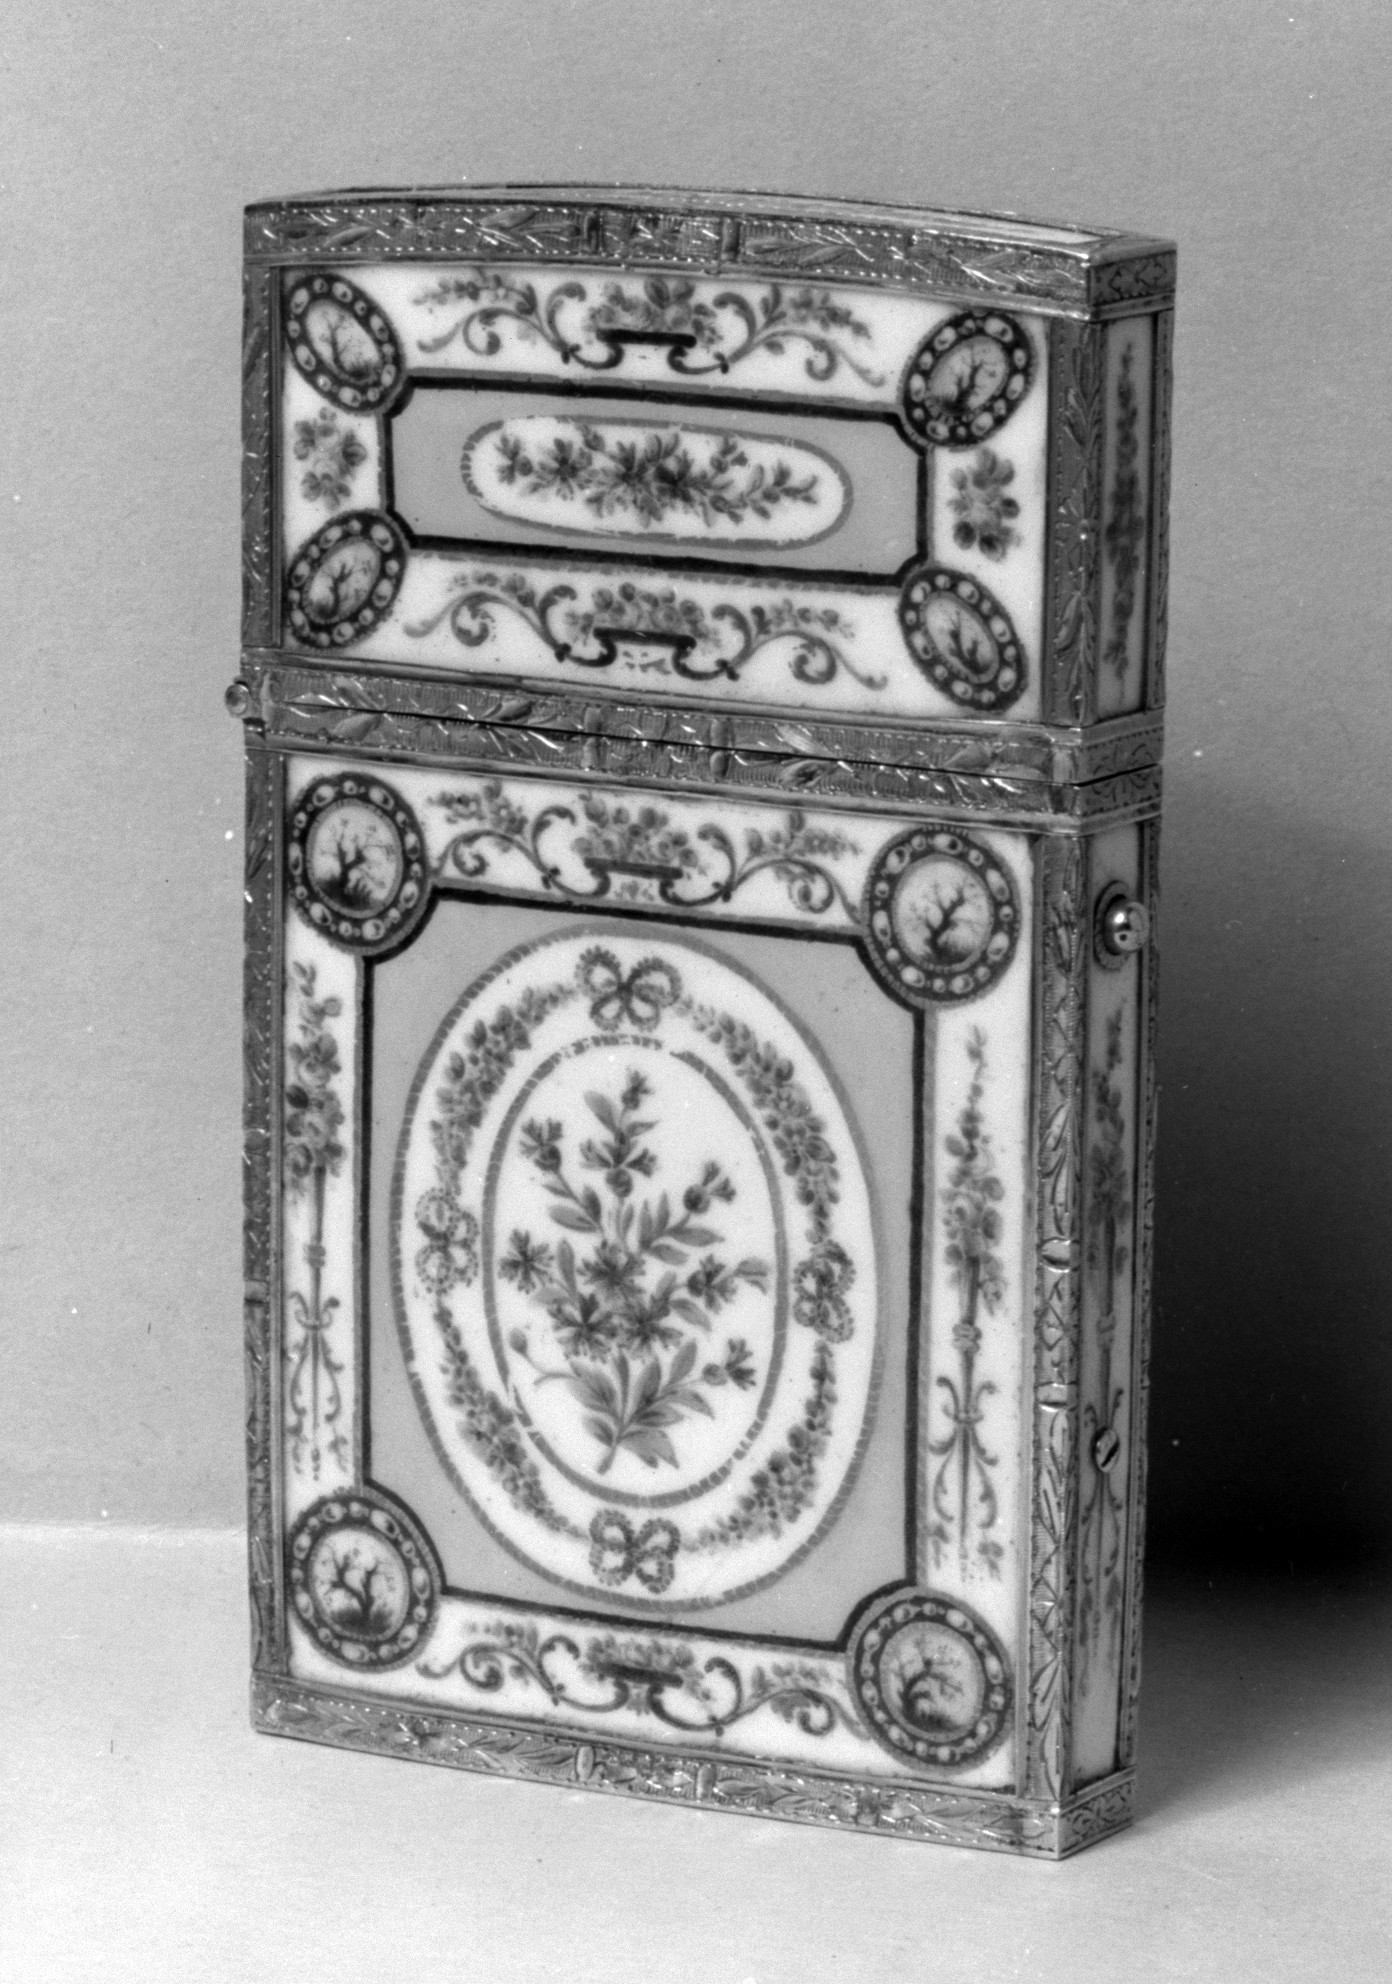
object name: souvenir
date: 1768-1775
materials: gold, ivory, porcelain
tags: flowers